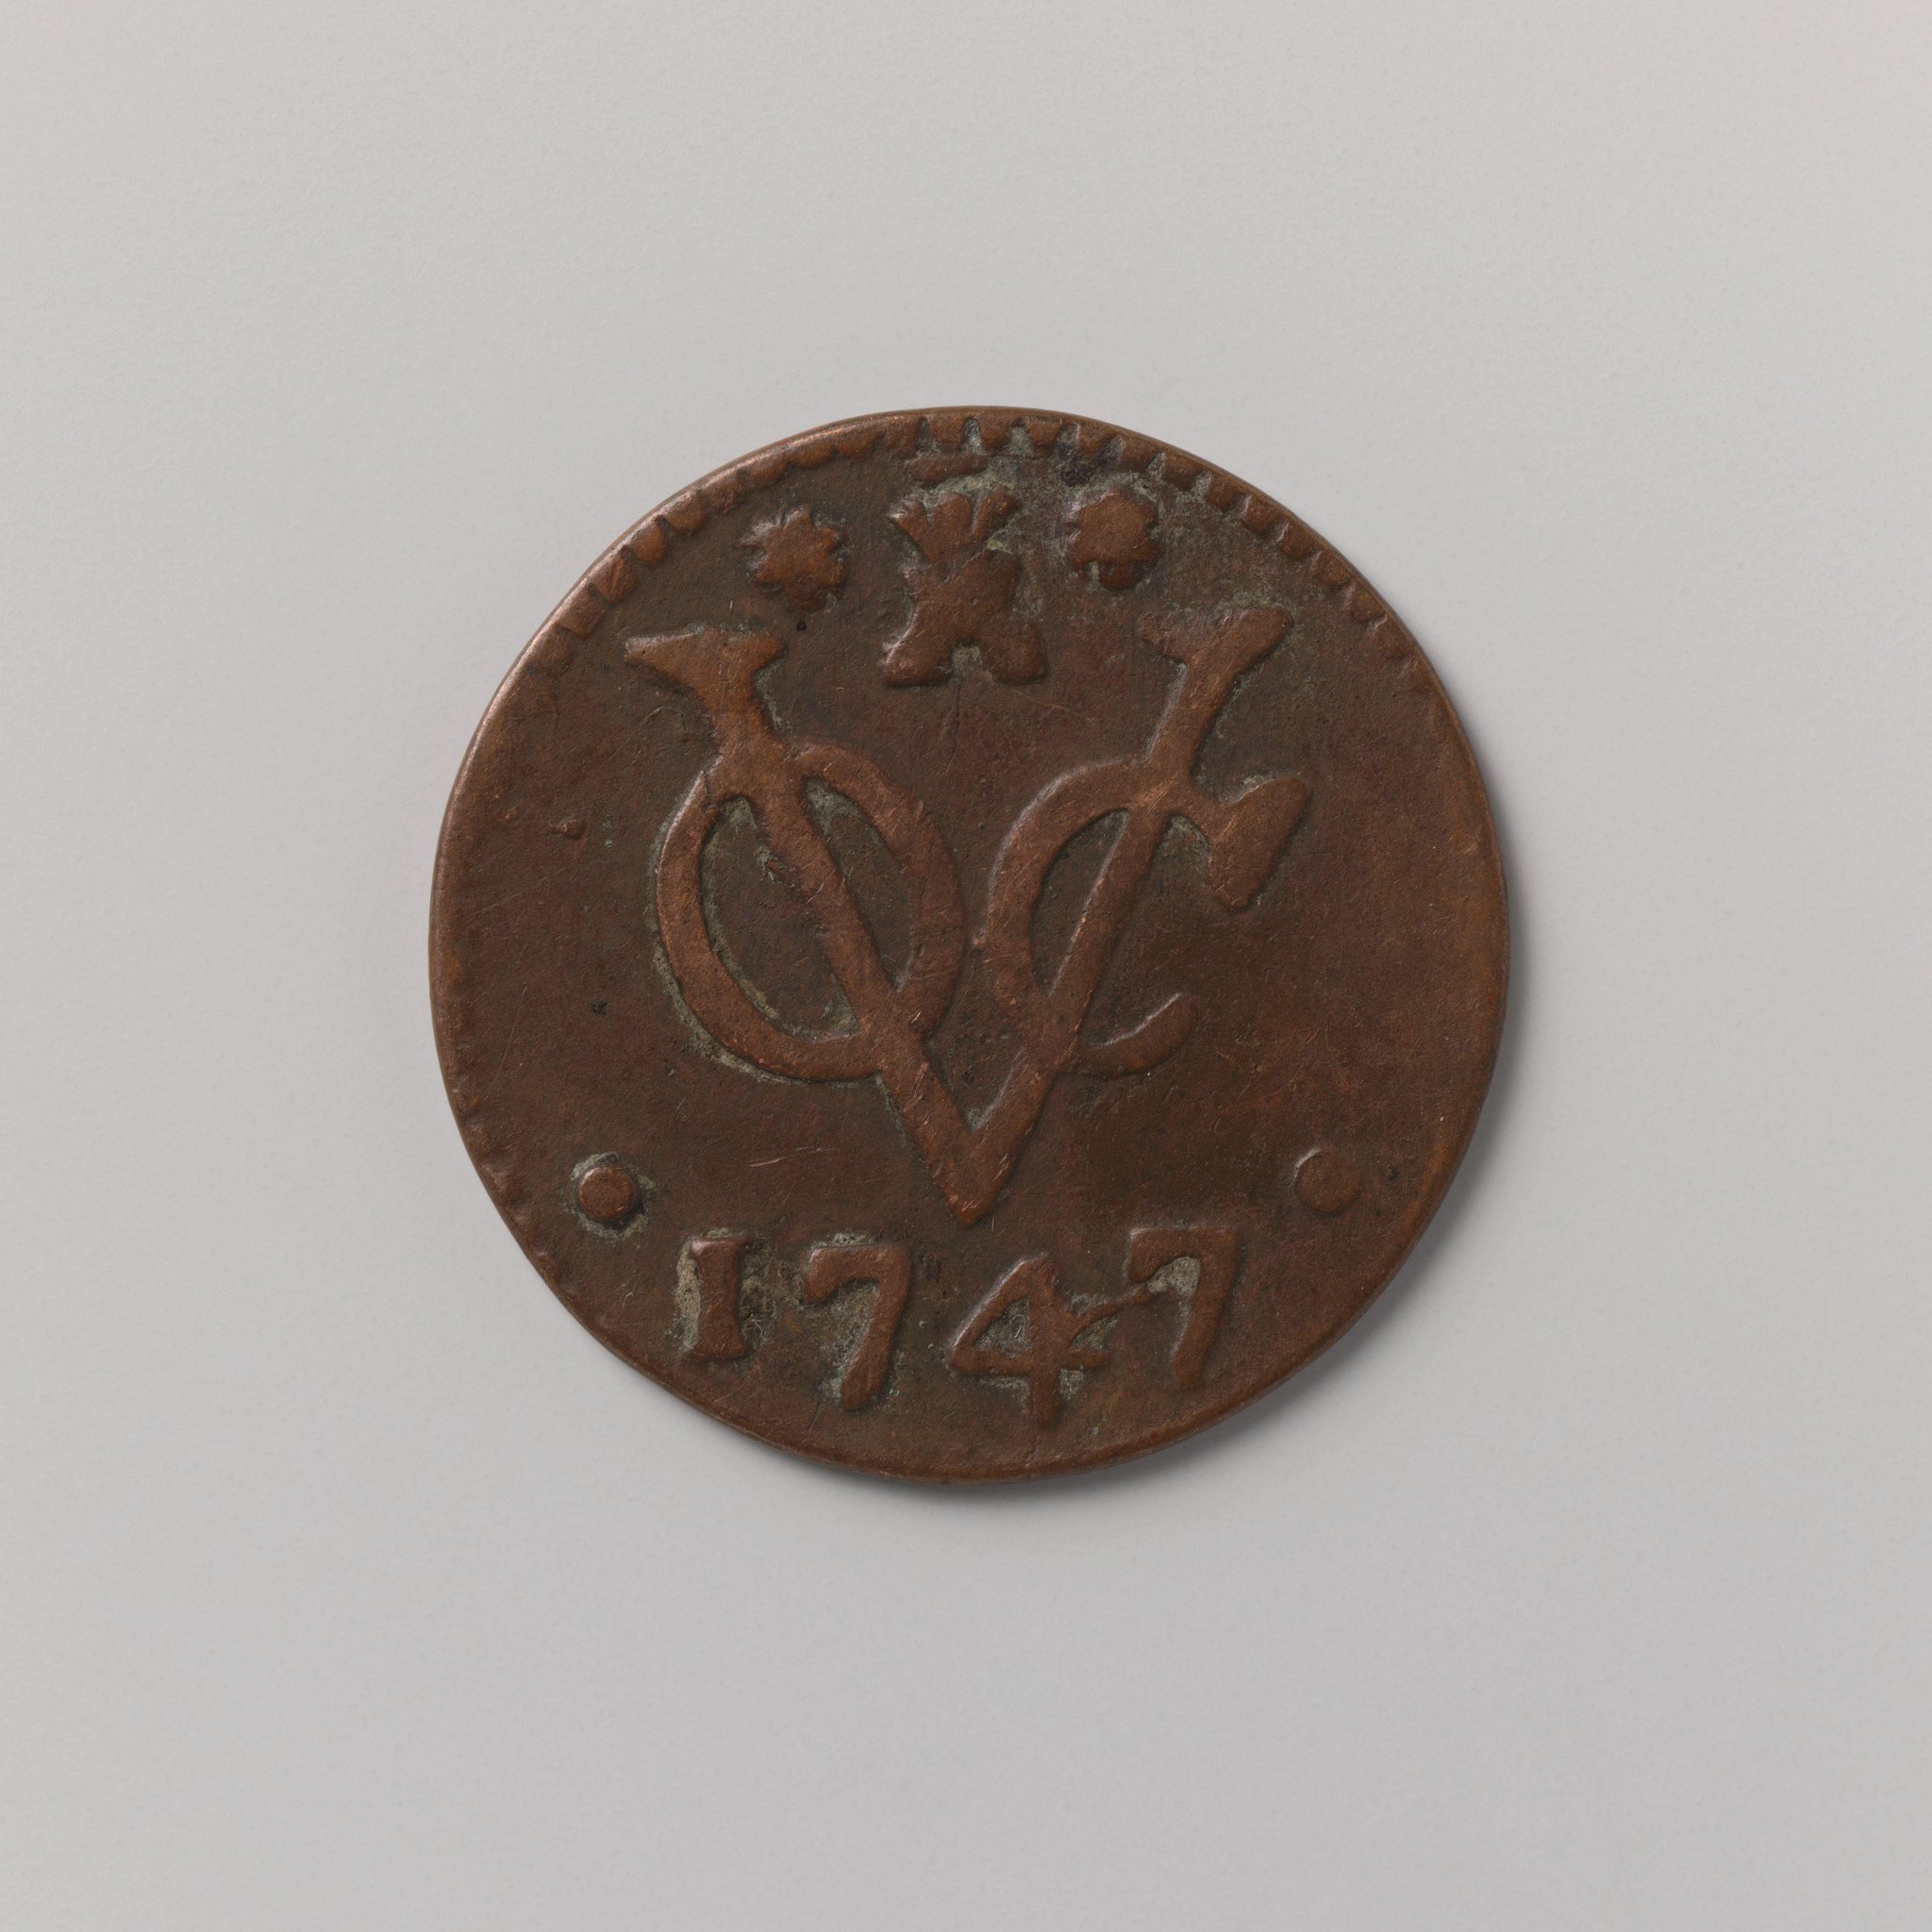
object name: coin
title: Duit van de VOC uit Zeeland, 1747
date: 1747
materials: copper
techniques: striking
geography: middelburg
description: Koperen munt. Voorzijde: gekroond wapenschild van Zeeland. Keerzijde: monogram van de VOC, waarboven muntteken en waaronder jaartal. Gladde rand.